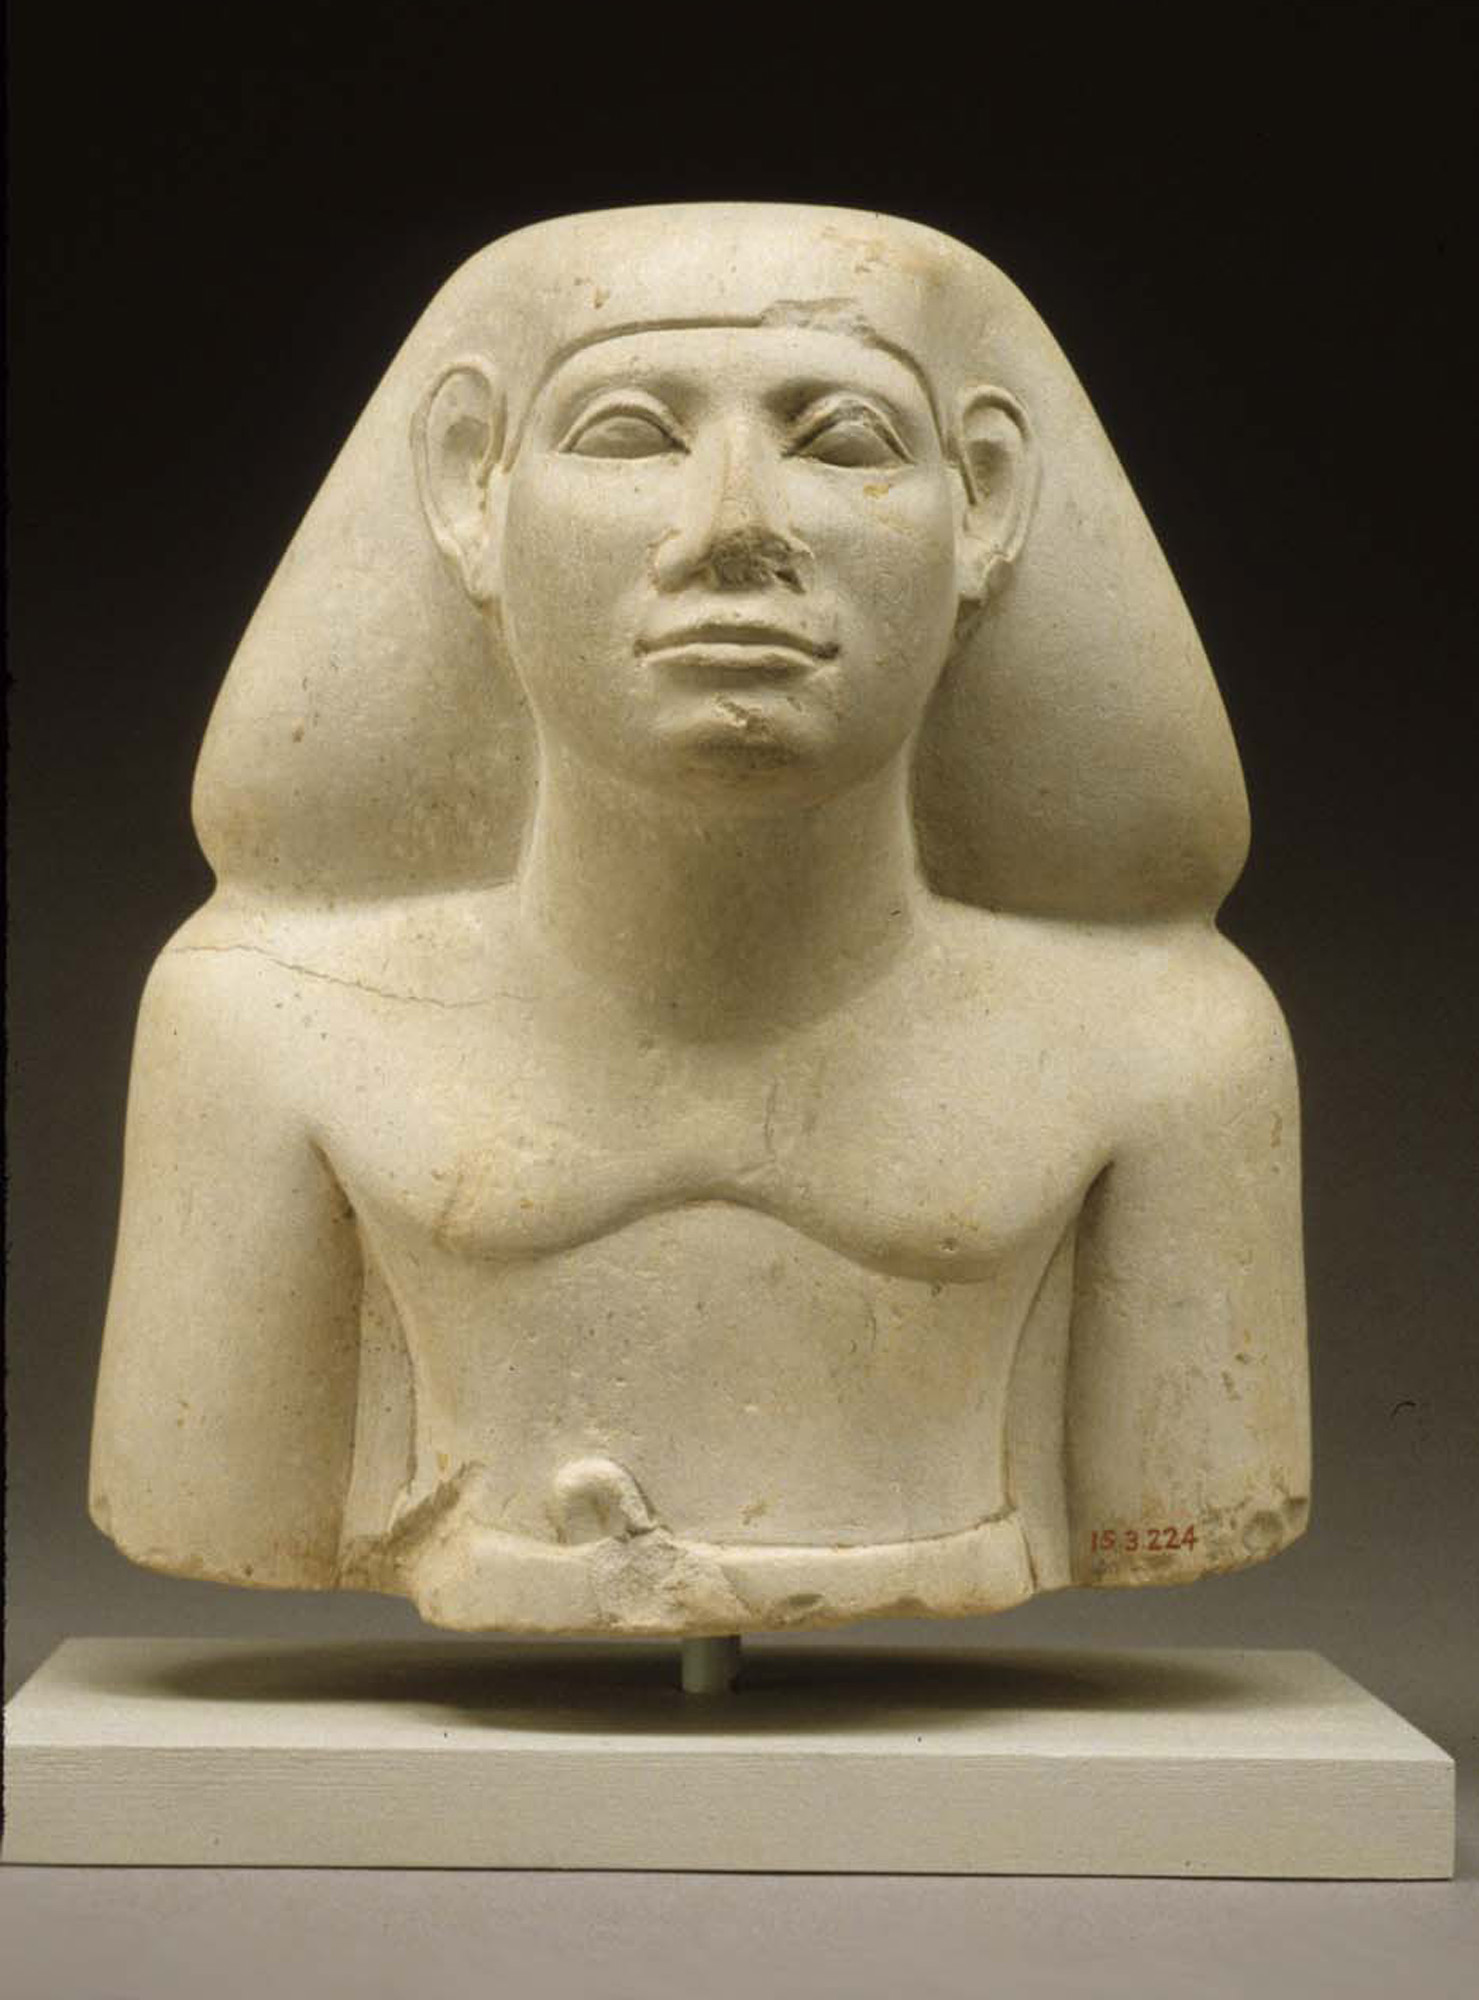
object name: bust, male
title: Upper part of male statue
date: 1850-1640 BCE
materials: limestone, paint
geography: egypt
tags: men